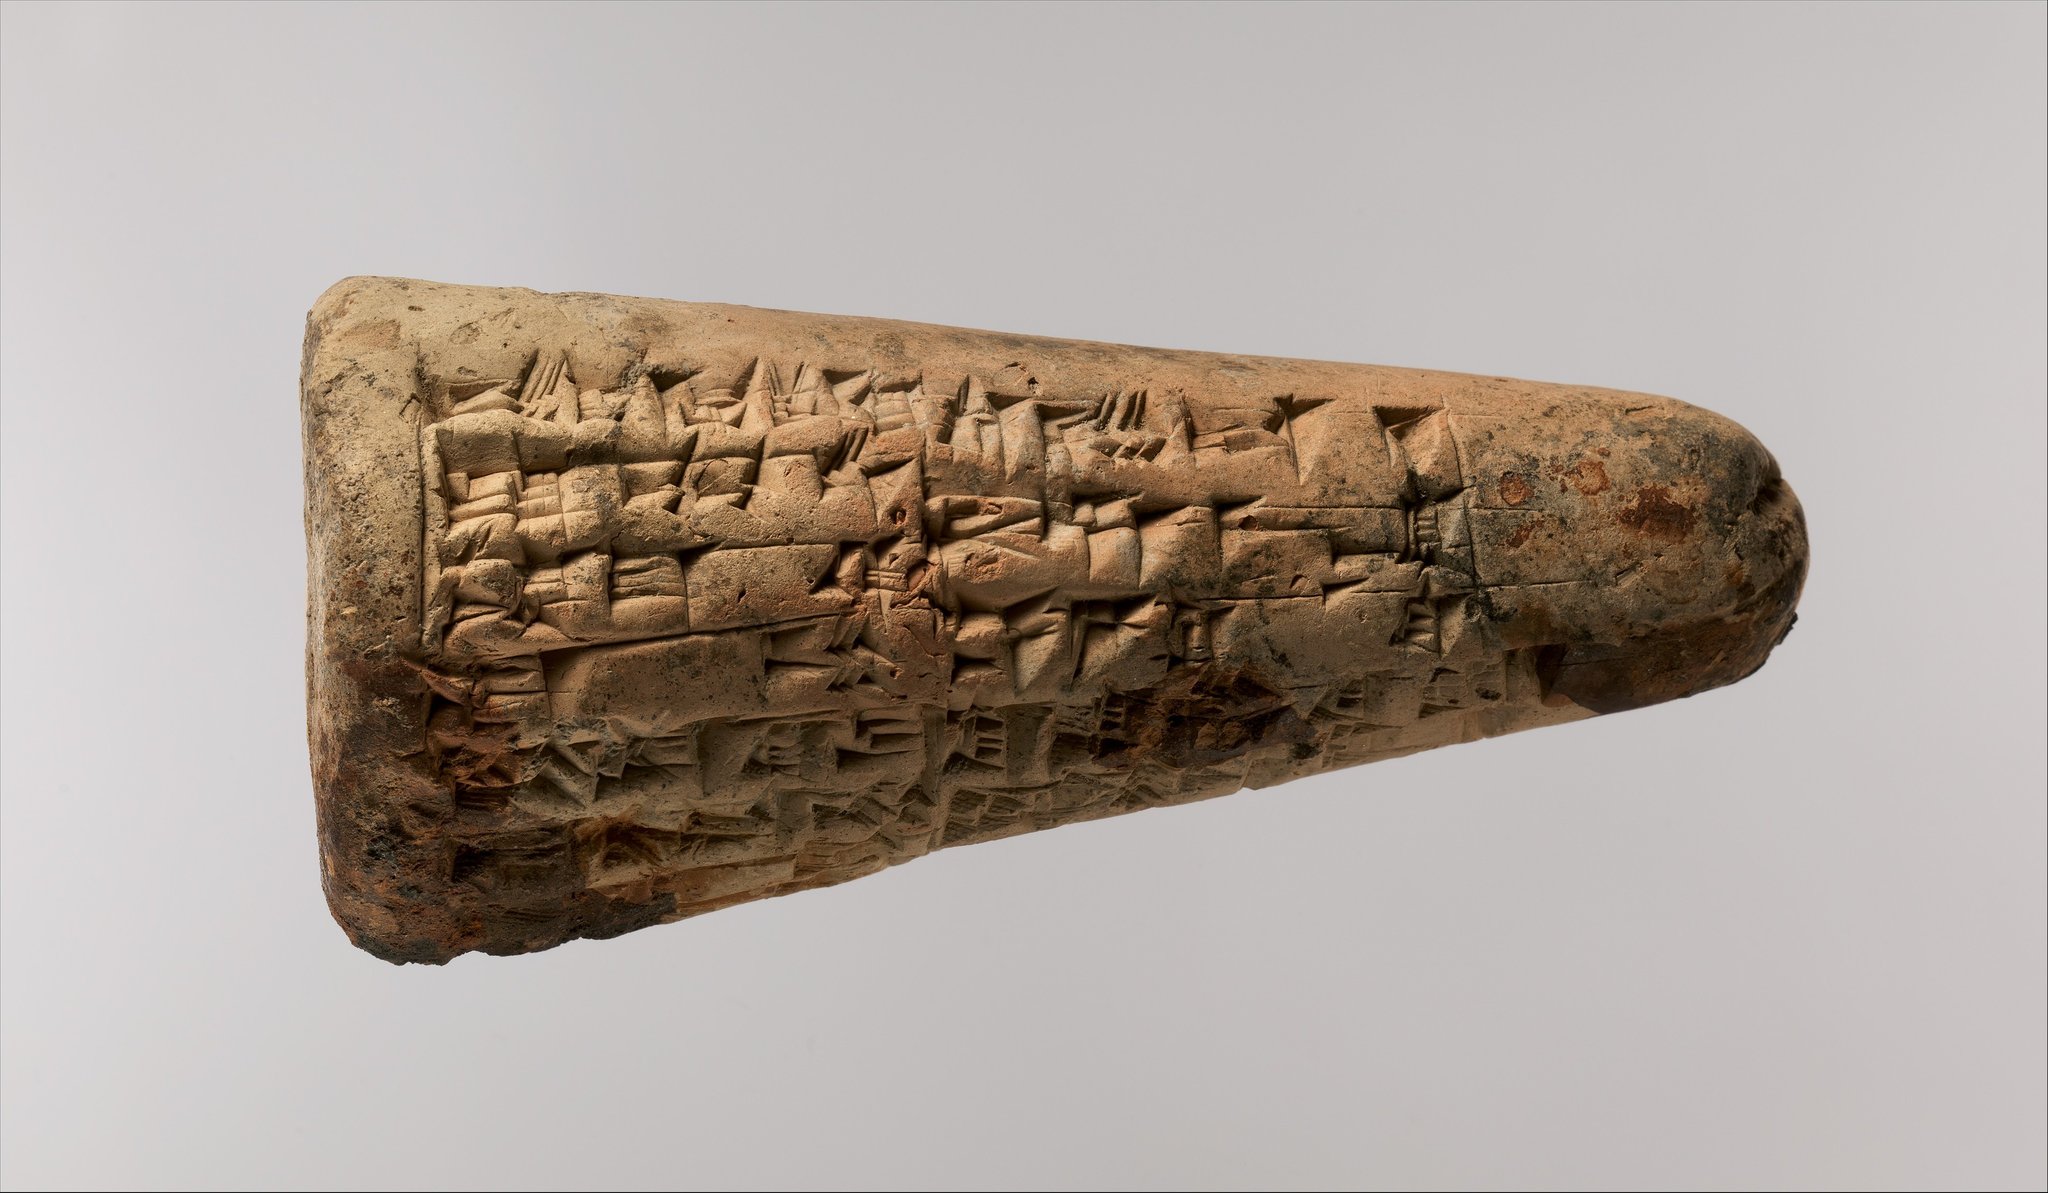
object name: cuneiform cone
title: Votive cone with cuneiform inscription of Lipit-Eshtar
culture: isin-larsa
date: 1934-1924 BCE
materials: clay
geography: mesopotamia